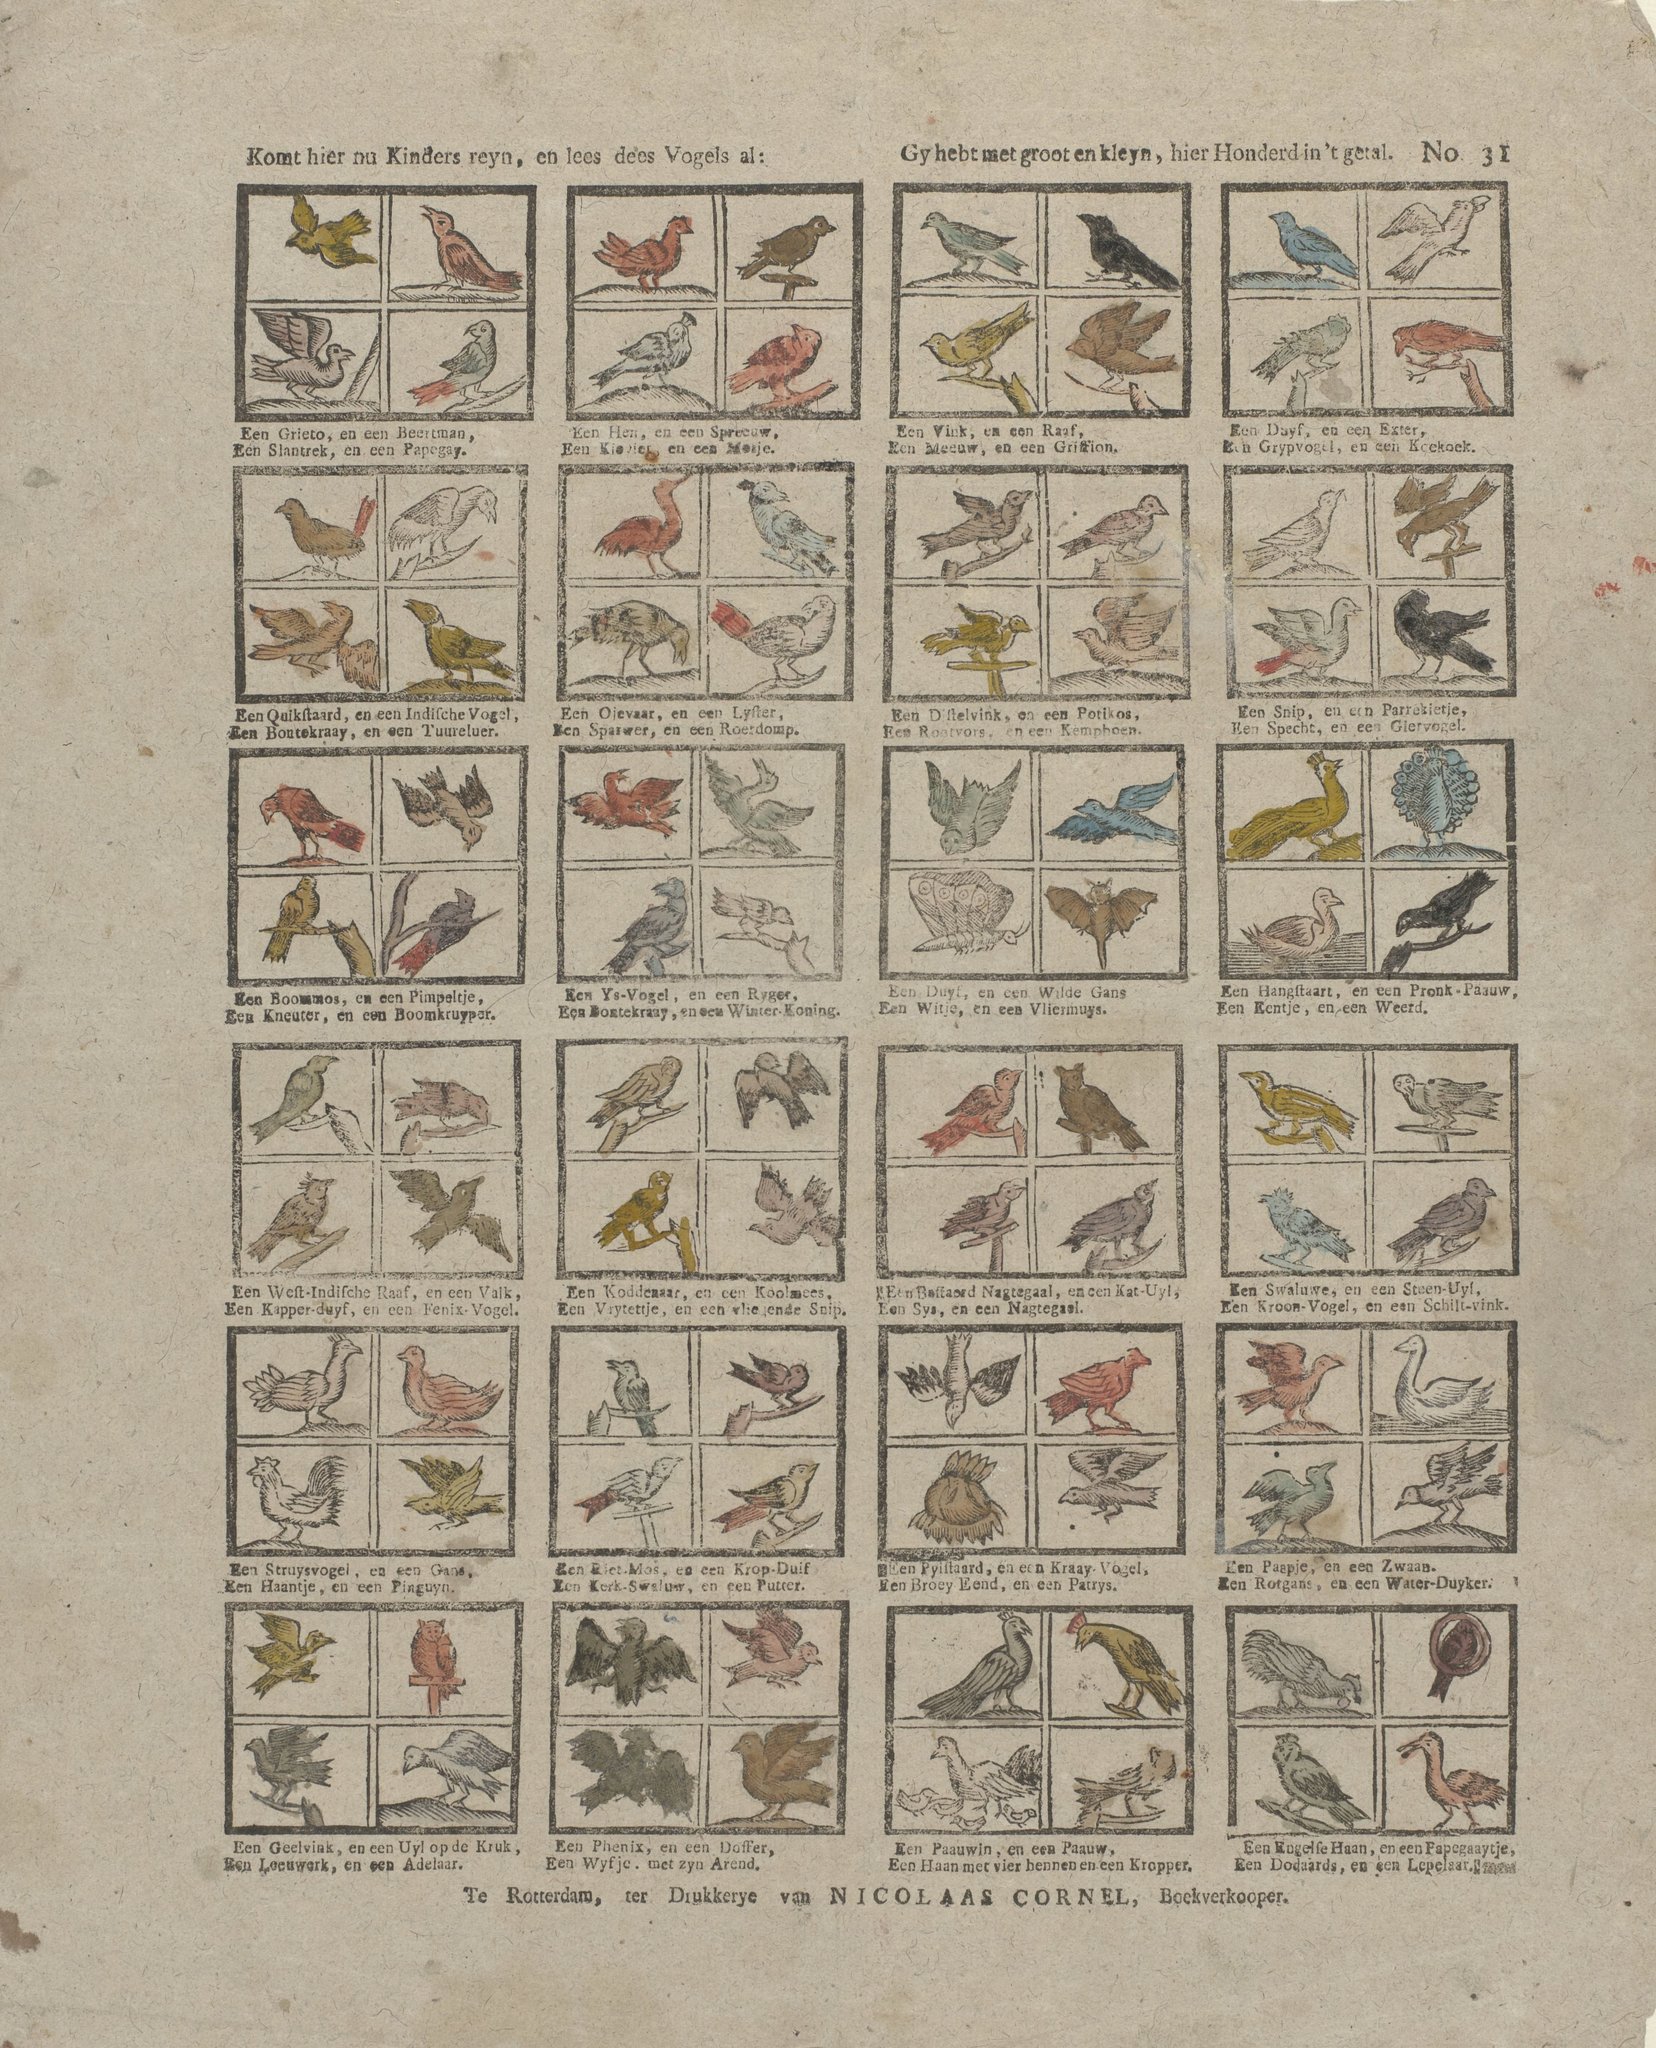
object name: print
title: Komt hier nu kinders reyn, en lees dees vogels al: / Gy hebt met groot en kleyn, hier honderd in 't getal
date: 1783-1800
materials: paper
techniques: colour, letterpress printing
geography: rotterdam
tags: flying mammals: bat, birds, insects: butterfly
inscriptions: collector's mark: Lugt 2760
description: Blad met 24 voorstellingen met elk vier gevleugelde dieren, zoals vogels, een uil, een vleermuis en een vlinder, de zgn. Groote Vogelkooi. Onder elke voorstelling de namen van de dieren. Genummerd rechtsboven: No. 31.